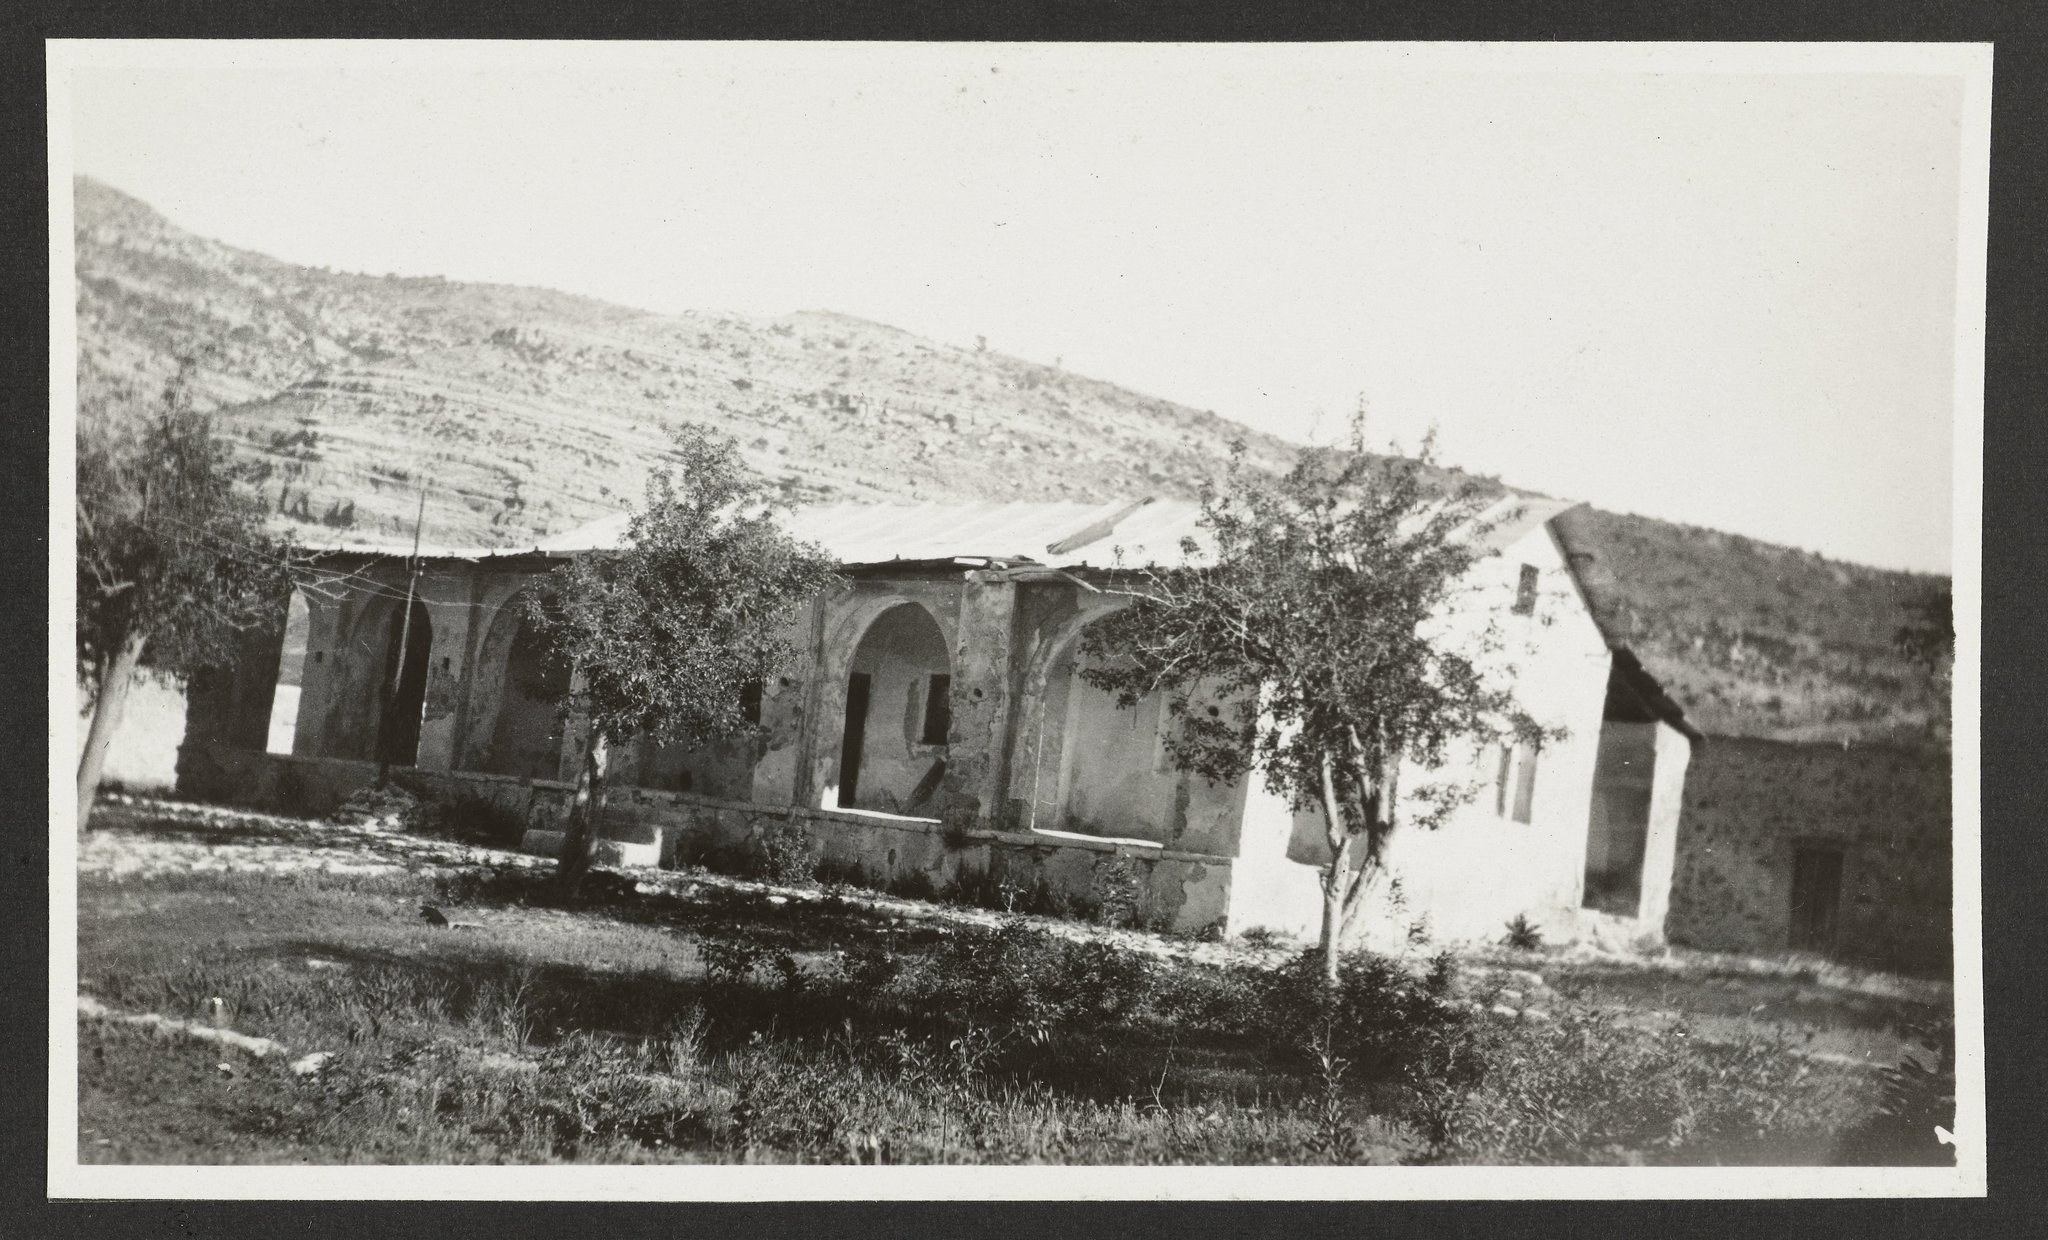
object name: photograph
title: Nachtverblyf tusschen Bushire en Shiraz, in een der "rest houses" van het Indo-European Telegraph Department.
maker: a.g.a. van eelde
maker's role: engineer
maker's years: 1862-1950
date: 1925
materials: cardboard, paper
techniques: gelatin silver print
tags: iran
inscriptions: number: ‘12.’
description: Een van de 'rest houses' van het Indo-European Telegraph Department tussen Bushire en Shiraz, nachtverblijf van de fotograaf.